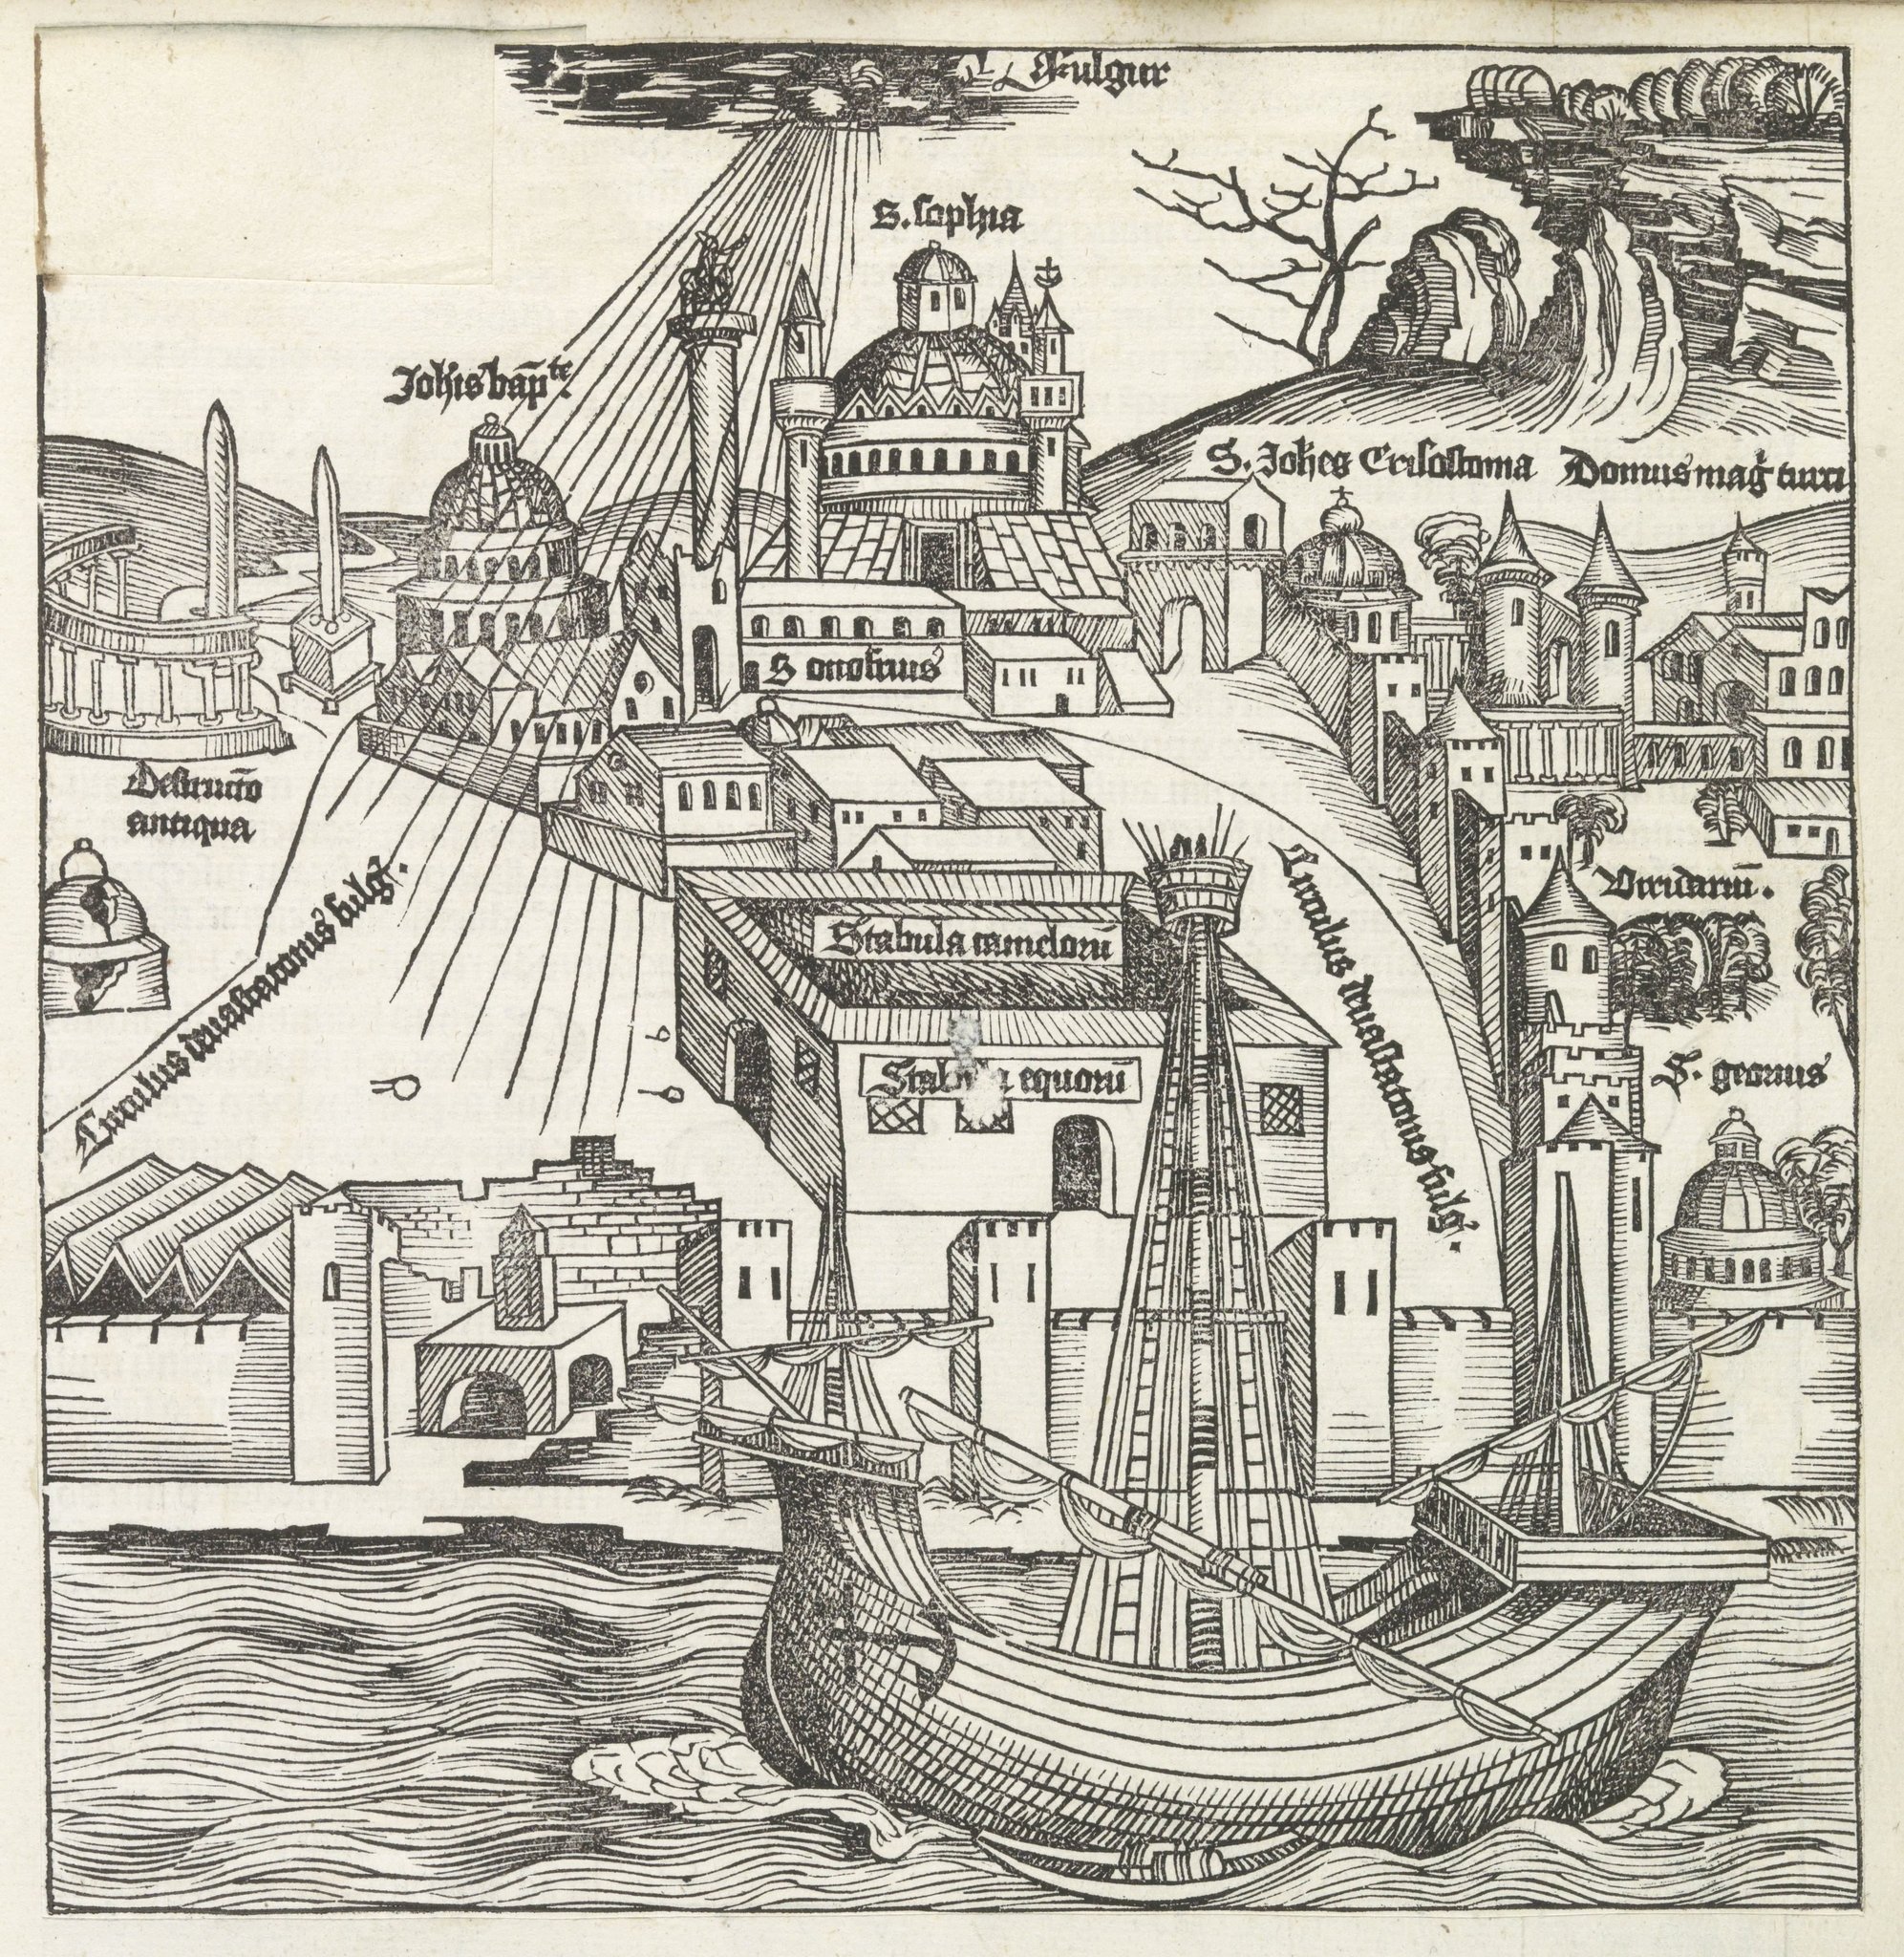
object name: album leaf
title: Gezicht op Constantinopel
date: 1493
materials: paper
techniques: letterpress printing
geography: nuremberg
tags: city-view, and landscape with man-made constructions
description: Gezicht op Constantinopel, op de voorgrond een schip. Midden op de achtergrond staat de Haga Sophia. Links daarvan de Zuil van Justinianus die volgens de tekst door zwaar onweer getroffen wordt. De prent maakt deel uit van een album.